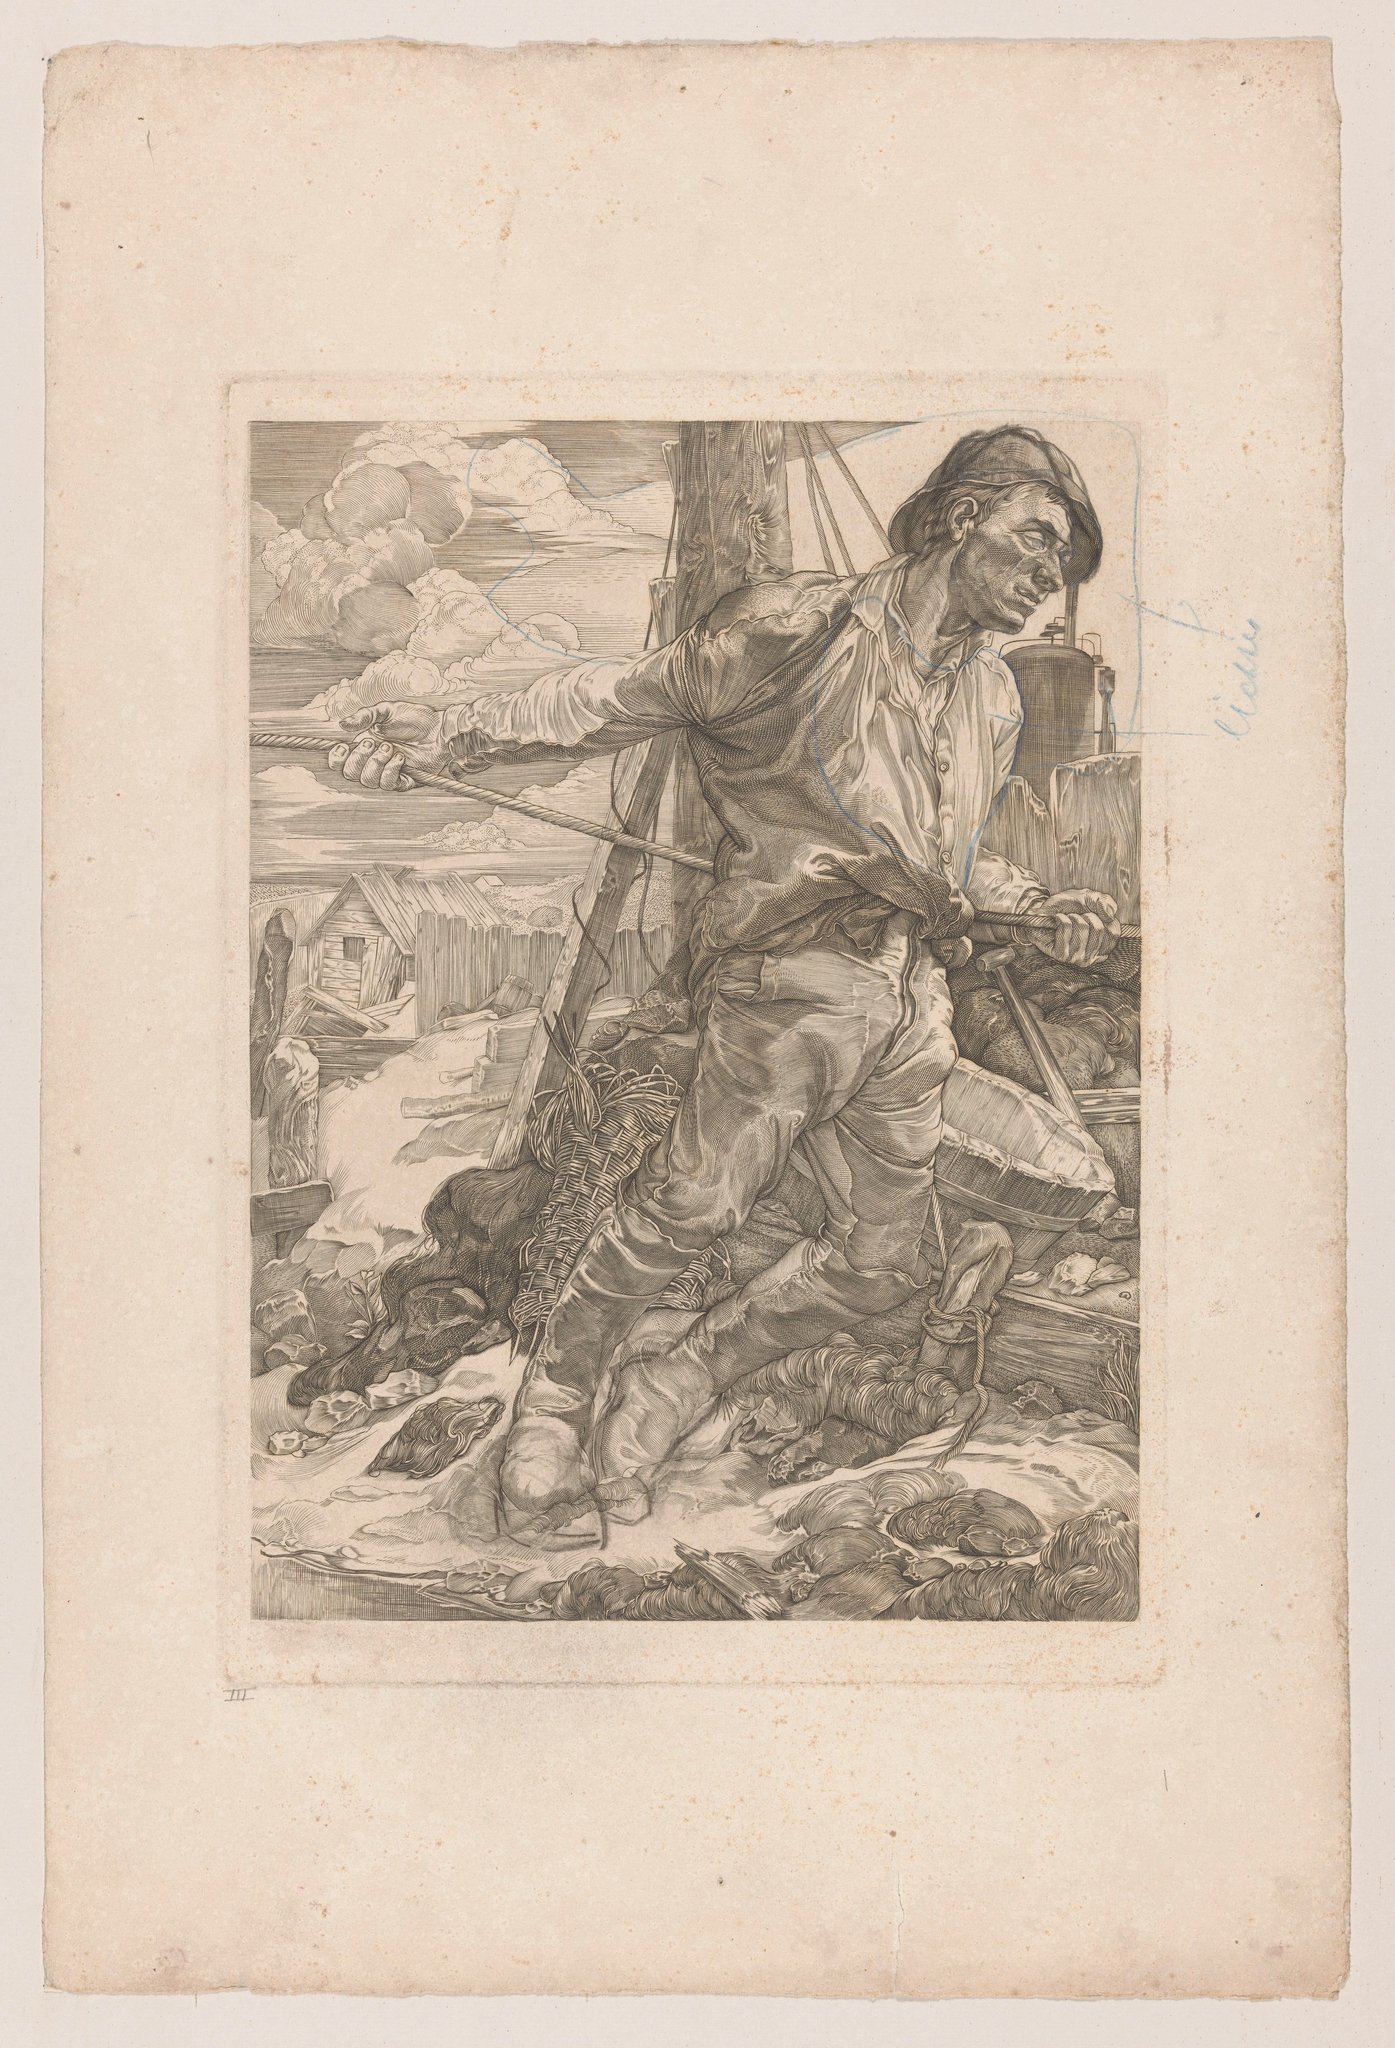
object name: print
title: Polderjongen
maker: johannes josephus aarts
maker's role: draughtsman, print maker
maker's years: 1871-1934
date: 1881-1934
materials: chalk, paper, pencil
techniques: engraving, intaglio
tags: working class, labourers, tools, aids, implements ~ crafts and industries: rope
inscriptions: annotation: ‘lichter’, collector's mark: Lugt 2166, collector's mark: Lugt 2228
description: Een arbeider die een hoed en laarzen draagt, laat een touw vieren. Op de achtergrond onder meer een schep, een kuip, een hek, een hut en een machine. Bij deze derde staat van de prent is onder meer het hoofd van de arbeider toegevoegd. Op verso een krijttekening van de arbeider.